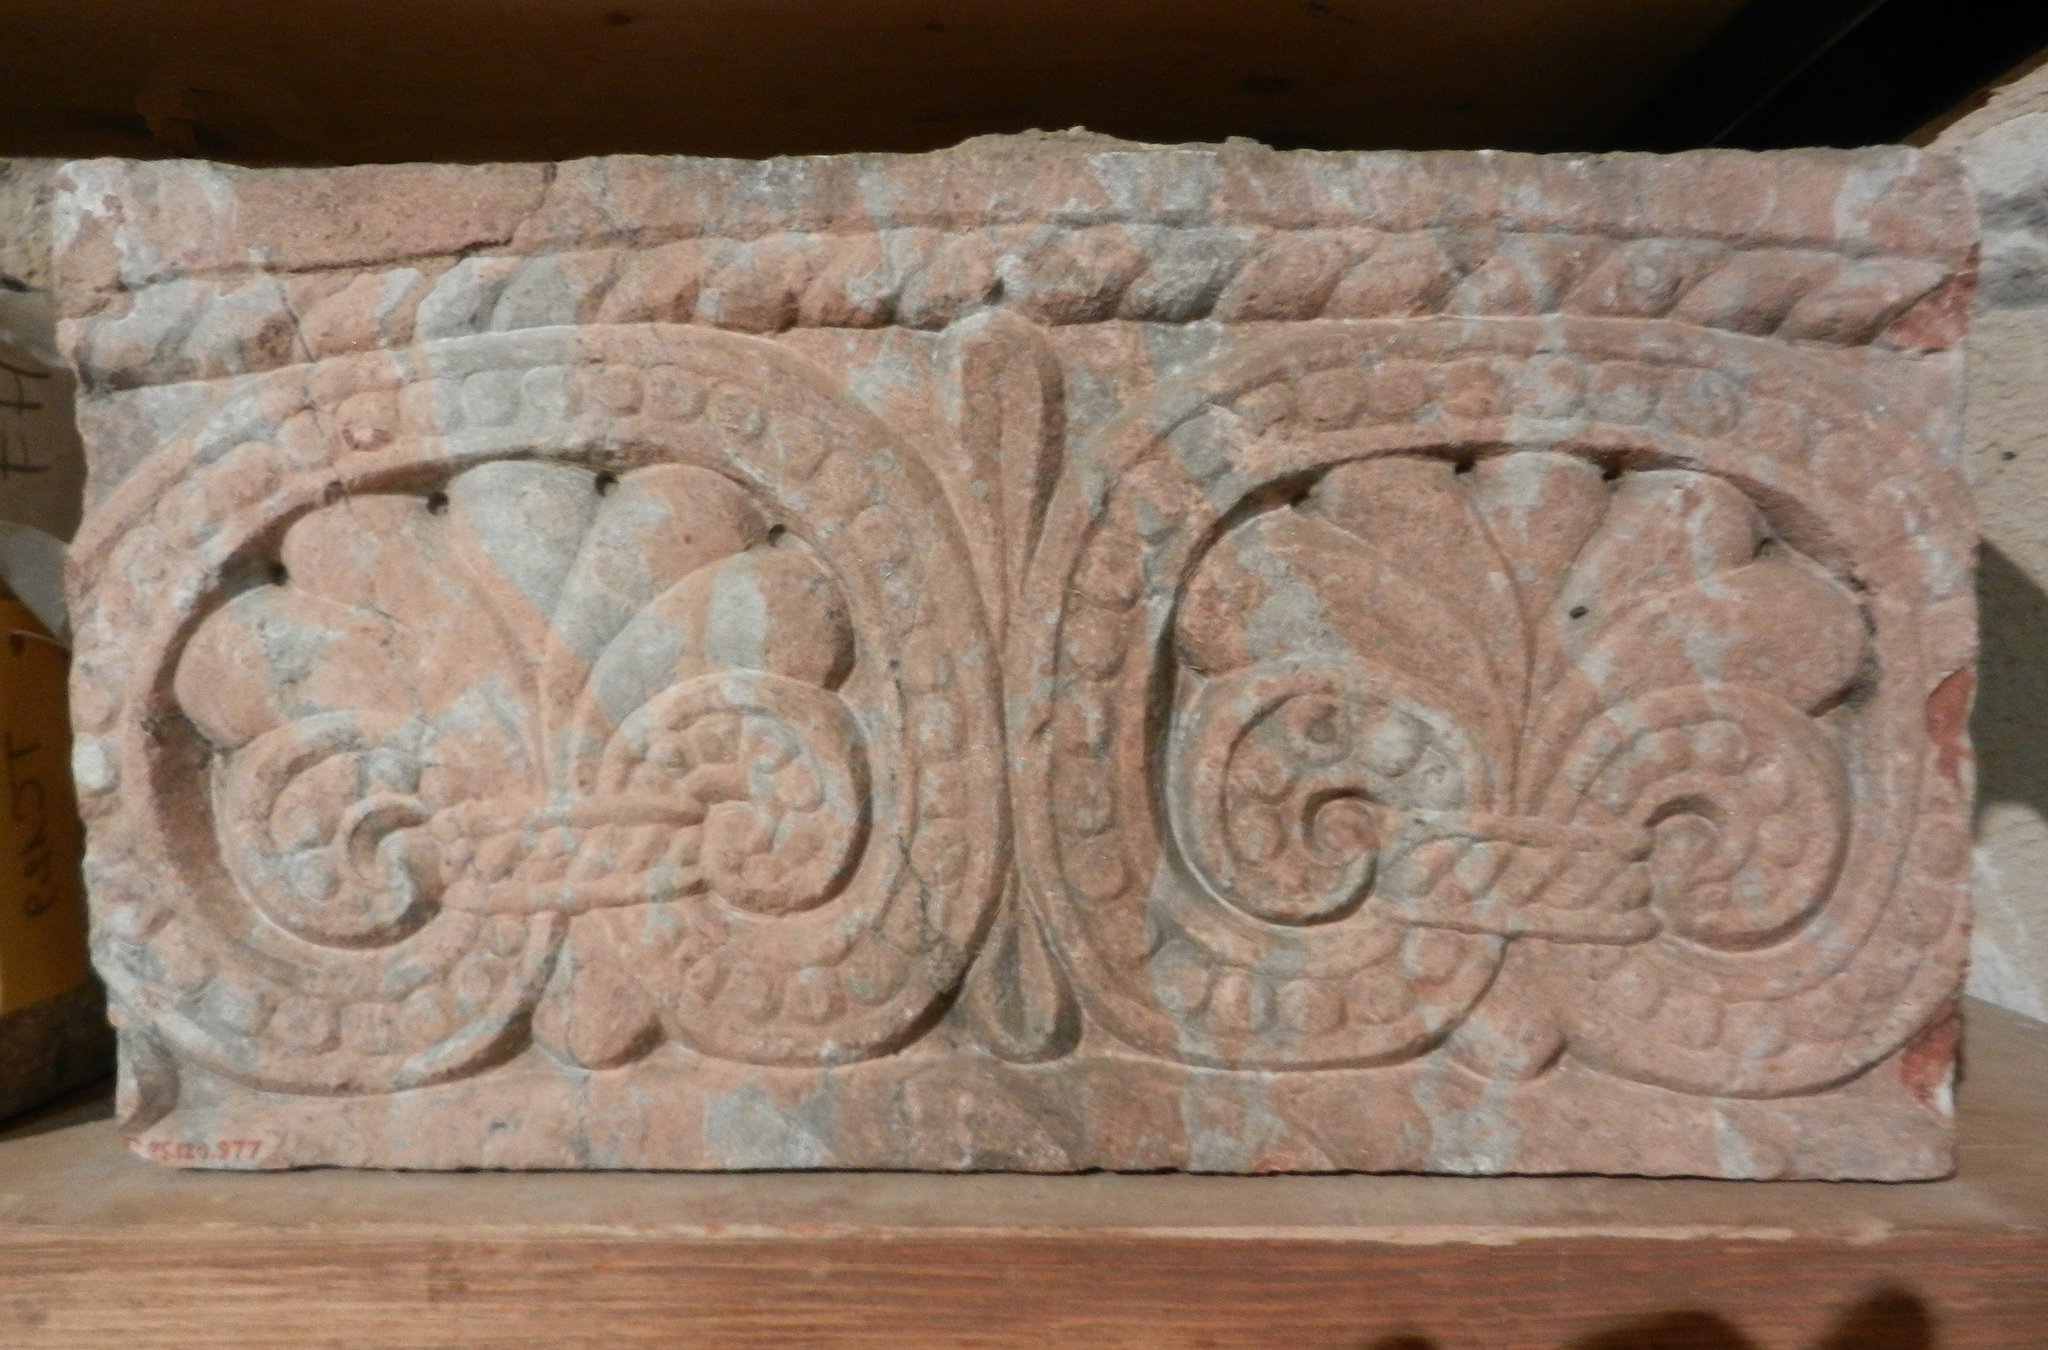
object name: fragment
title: Lintel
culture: catalan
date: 1130-1140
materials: marble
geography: france